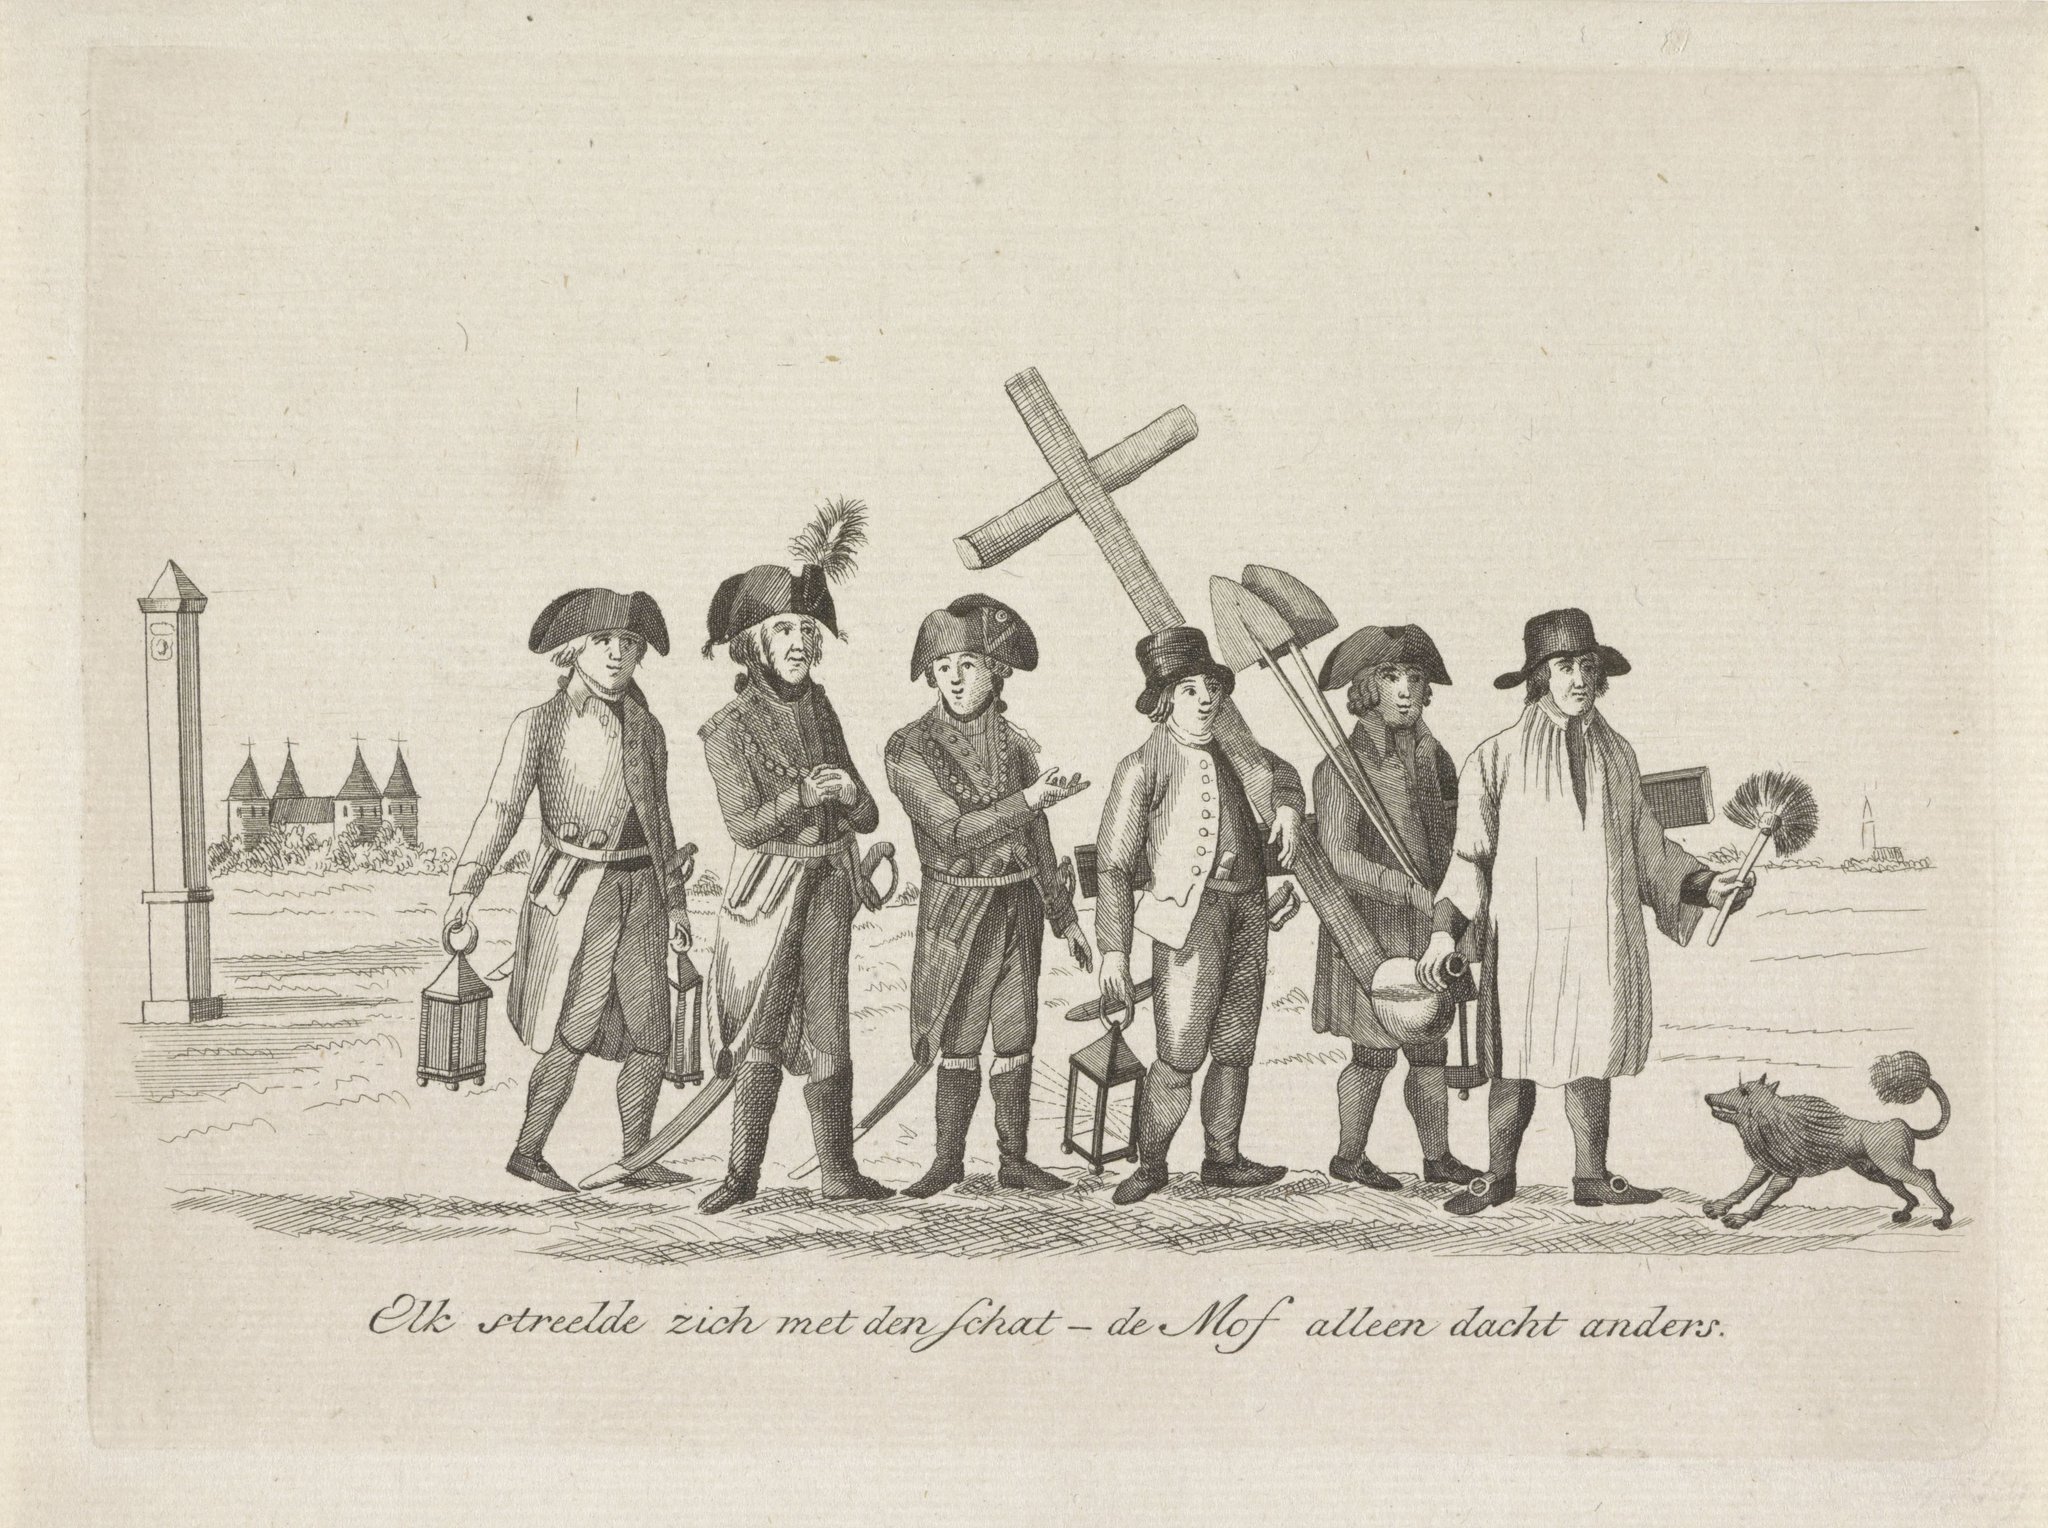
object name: print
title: Schatzoekers van Muiden, 1800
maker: Anonymous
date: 1800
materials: paper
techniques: etching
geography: netherlands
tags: amsterdam, digging for or finding of treasure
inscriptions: collector's mark: Lugt 2228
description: De schatzoekers van Muiden met spaden, wijwaterkwast, kruis en lantaarn in een soort processie onderweg naar de plaats van de vermeende schat. Illustratie van het verhaal van het bedrog van de bijgelovige katholieke luitenant-kolonel Dirk Cornelis van der Meulen door een Duitse oplichter, te Muiden in de nacht van 12 op 13 augustus 1800. Op de achtergrond het Muiderslot.